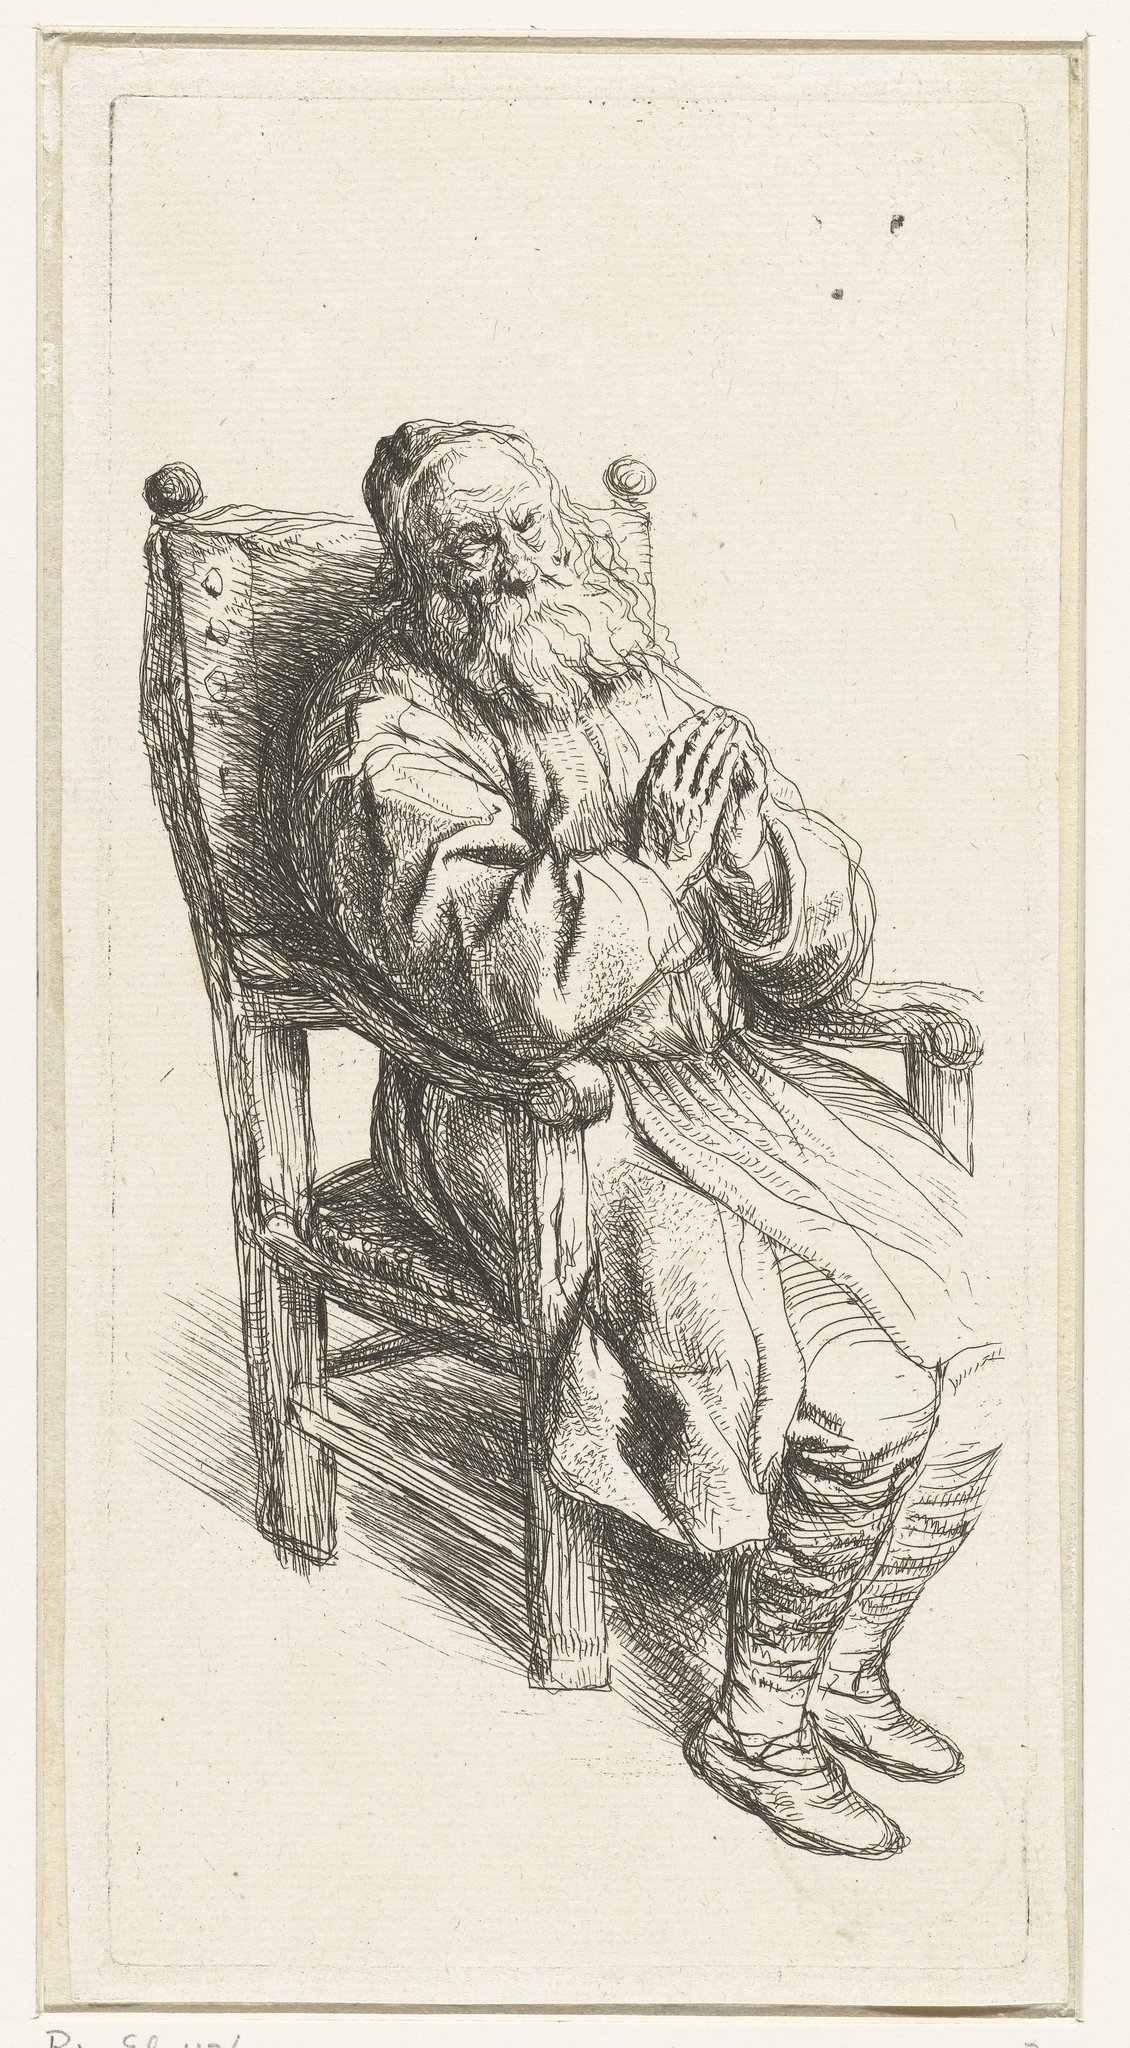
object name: print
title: Oude man in een leunstoel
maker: salomon koninck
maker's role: draughtsman, painter, print maker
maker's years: 1609-1656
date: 1619-1656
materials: paper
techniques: etching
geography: netherlands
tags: armchair, seat, old man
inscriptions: collector's mark: Lugt 240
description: Een oude man in een leunstoel, met de ogen gesloten en handen bij elkaar.